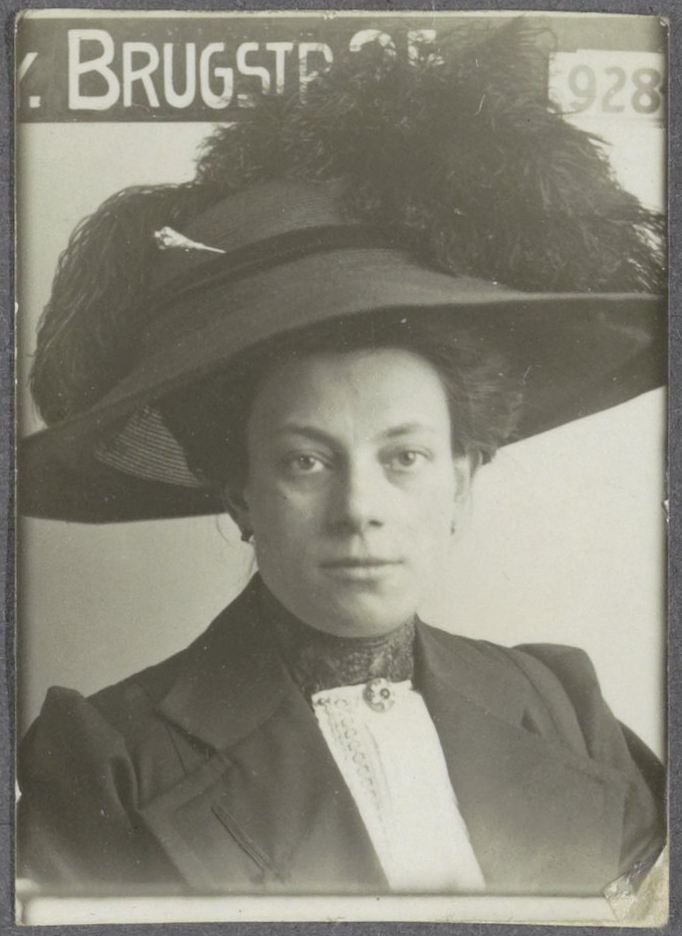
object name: album leaf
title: Portret van een vrouw met een hoed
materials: paper, cardboard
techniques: gelatin silver print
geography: groningen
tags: adult woman, historical persons, head-gear: hat, netherlands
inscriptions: number: ‘928’, address: ‘Brugstraat 25’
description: Onderdeel van Fotoalbum met portretten vervaardigd door Nederlandse studio's waaronder automaatfoto's.